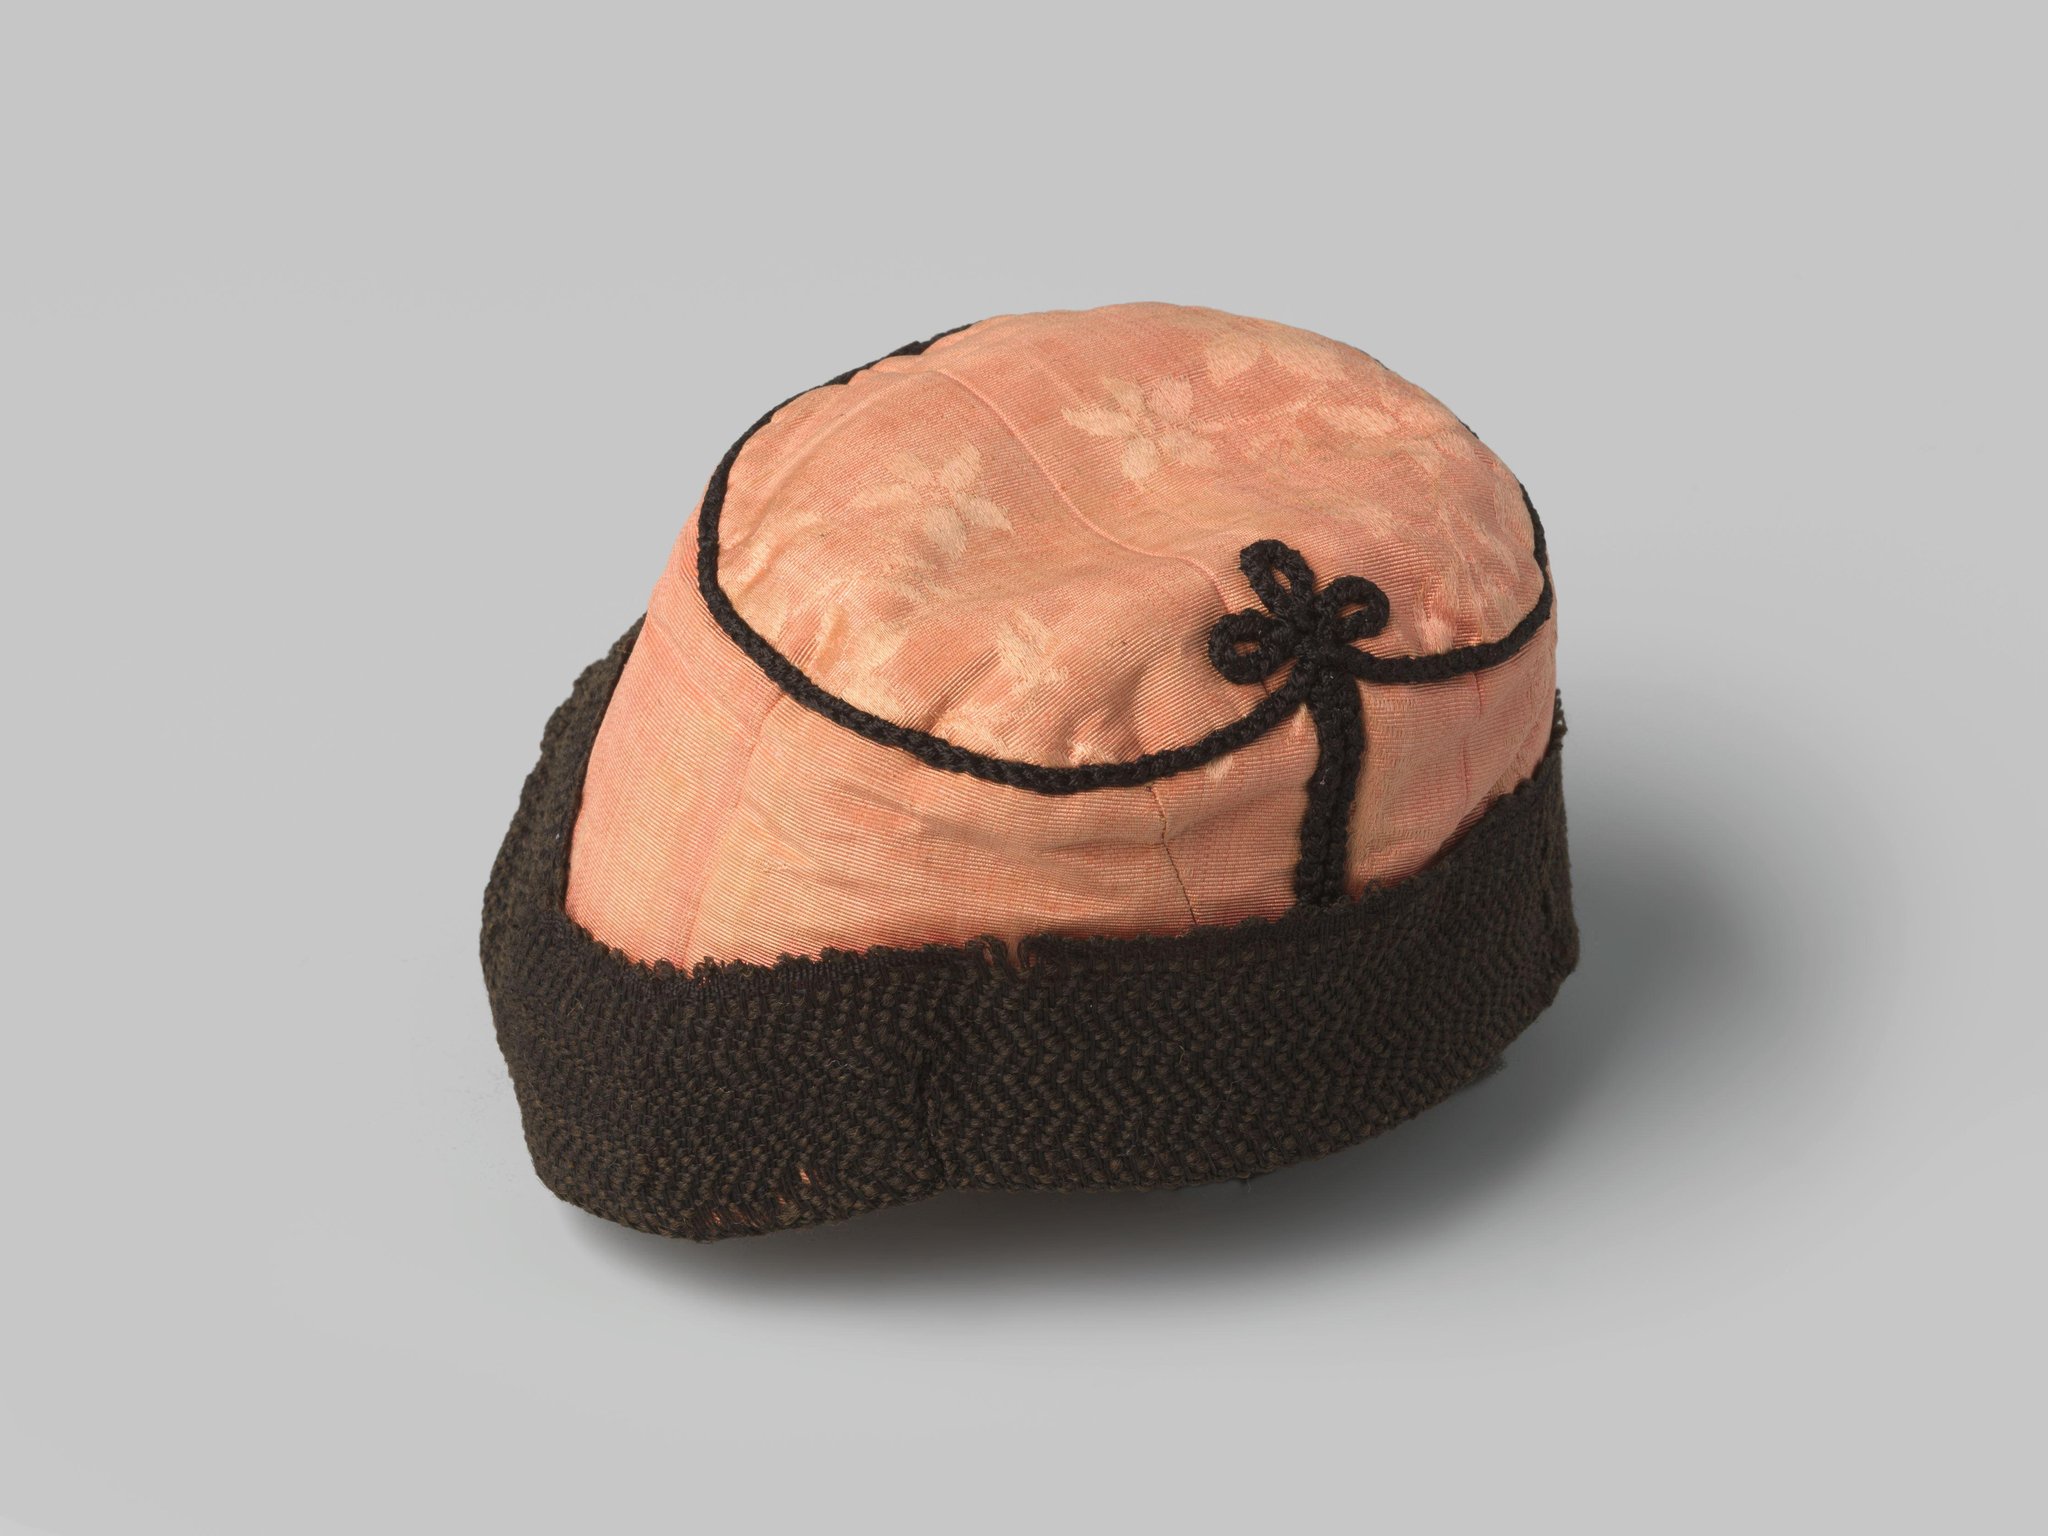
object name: cap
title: Kap van roze damast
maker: Anonymous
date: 1800-1900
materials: felt, silk, wool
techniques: damask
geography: friesland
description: Kap van roze damast met bloemen, zonder koralen maar met zwart lint, gevoerd met naturel kleurig vilten wol.